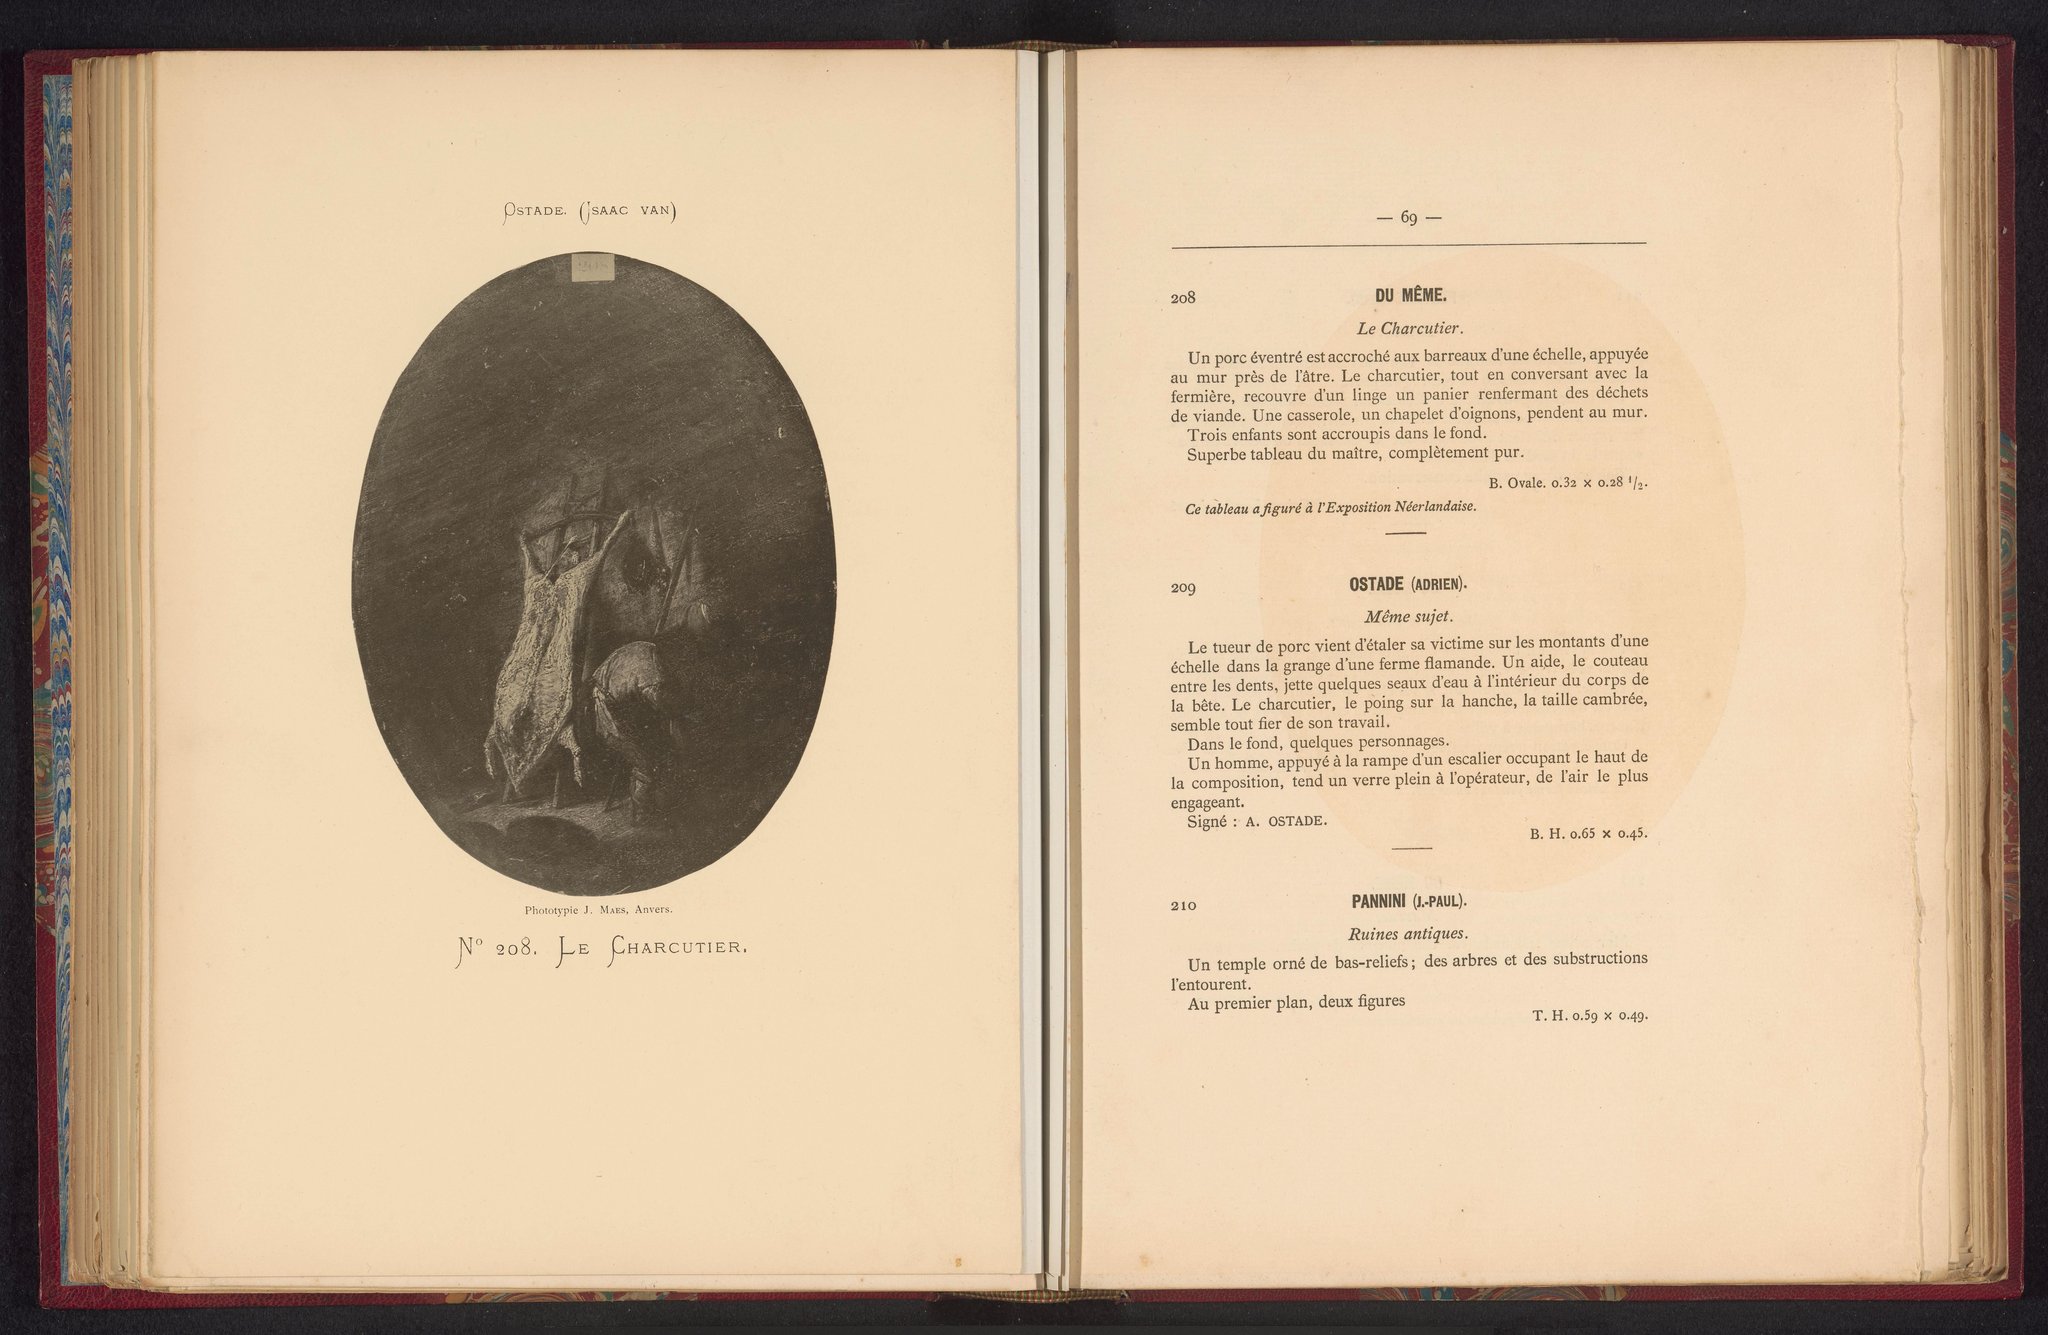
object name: page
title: Reproductie van een werk van een gespalkt dierenkarkas van Isaac van Ostade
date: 1878-1883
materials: paper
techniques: photograph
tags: spoils of the hunt, game, venison, painting, drawing and the graphic arts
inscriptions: number: ‘No. 208’